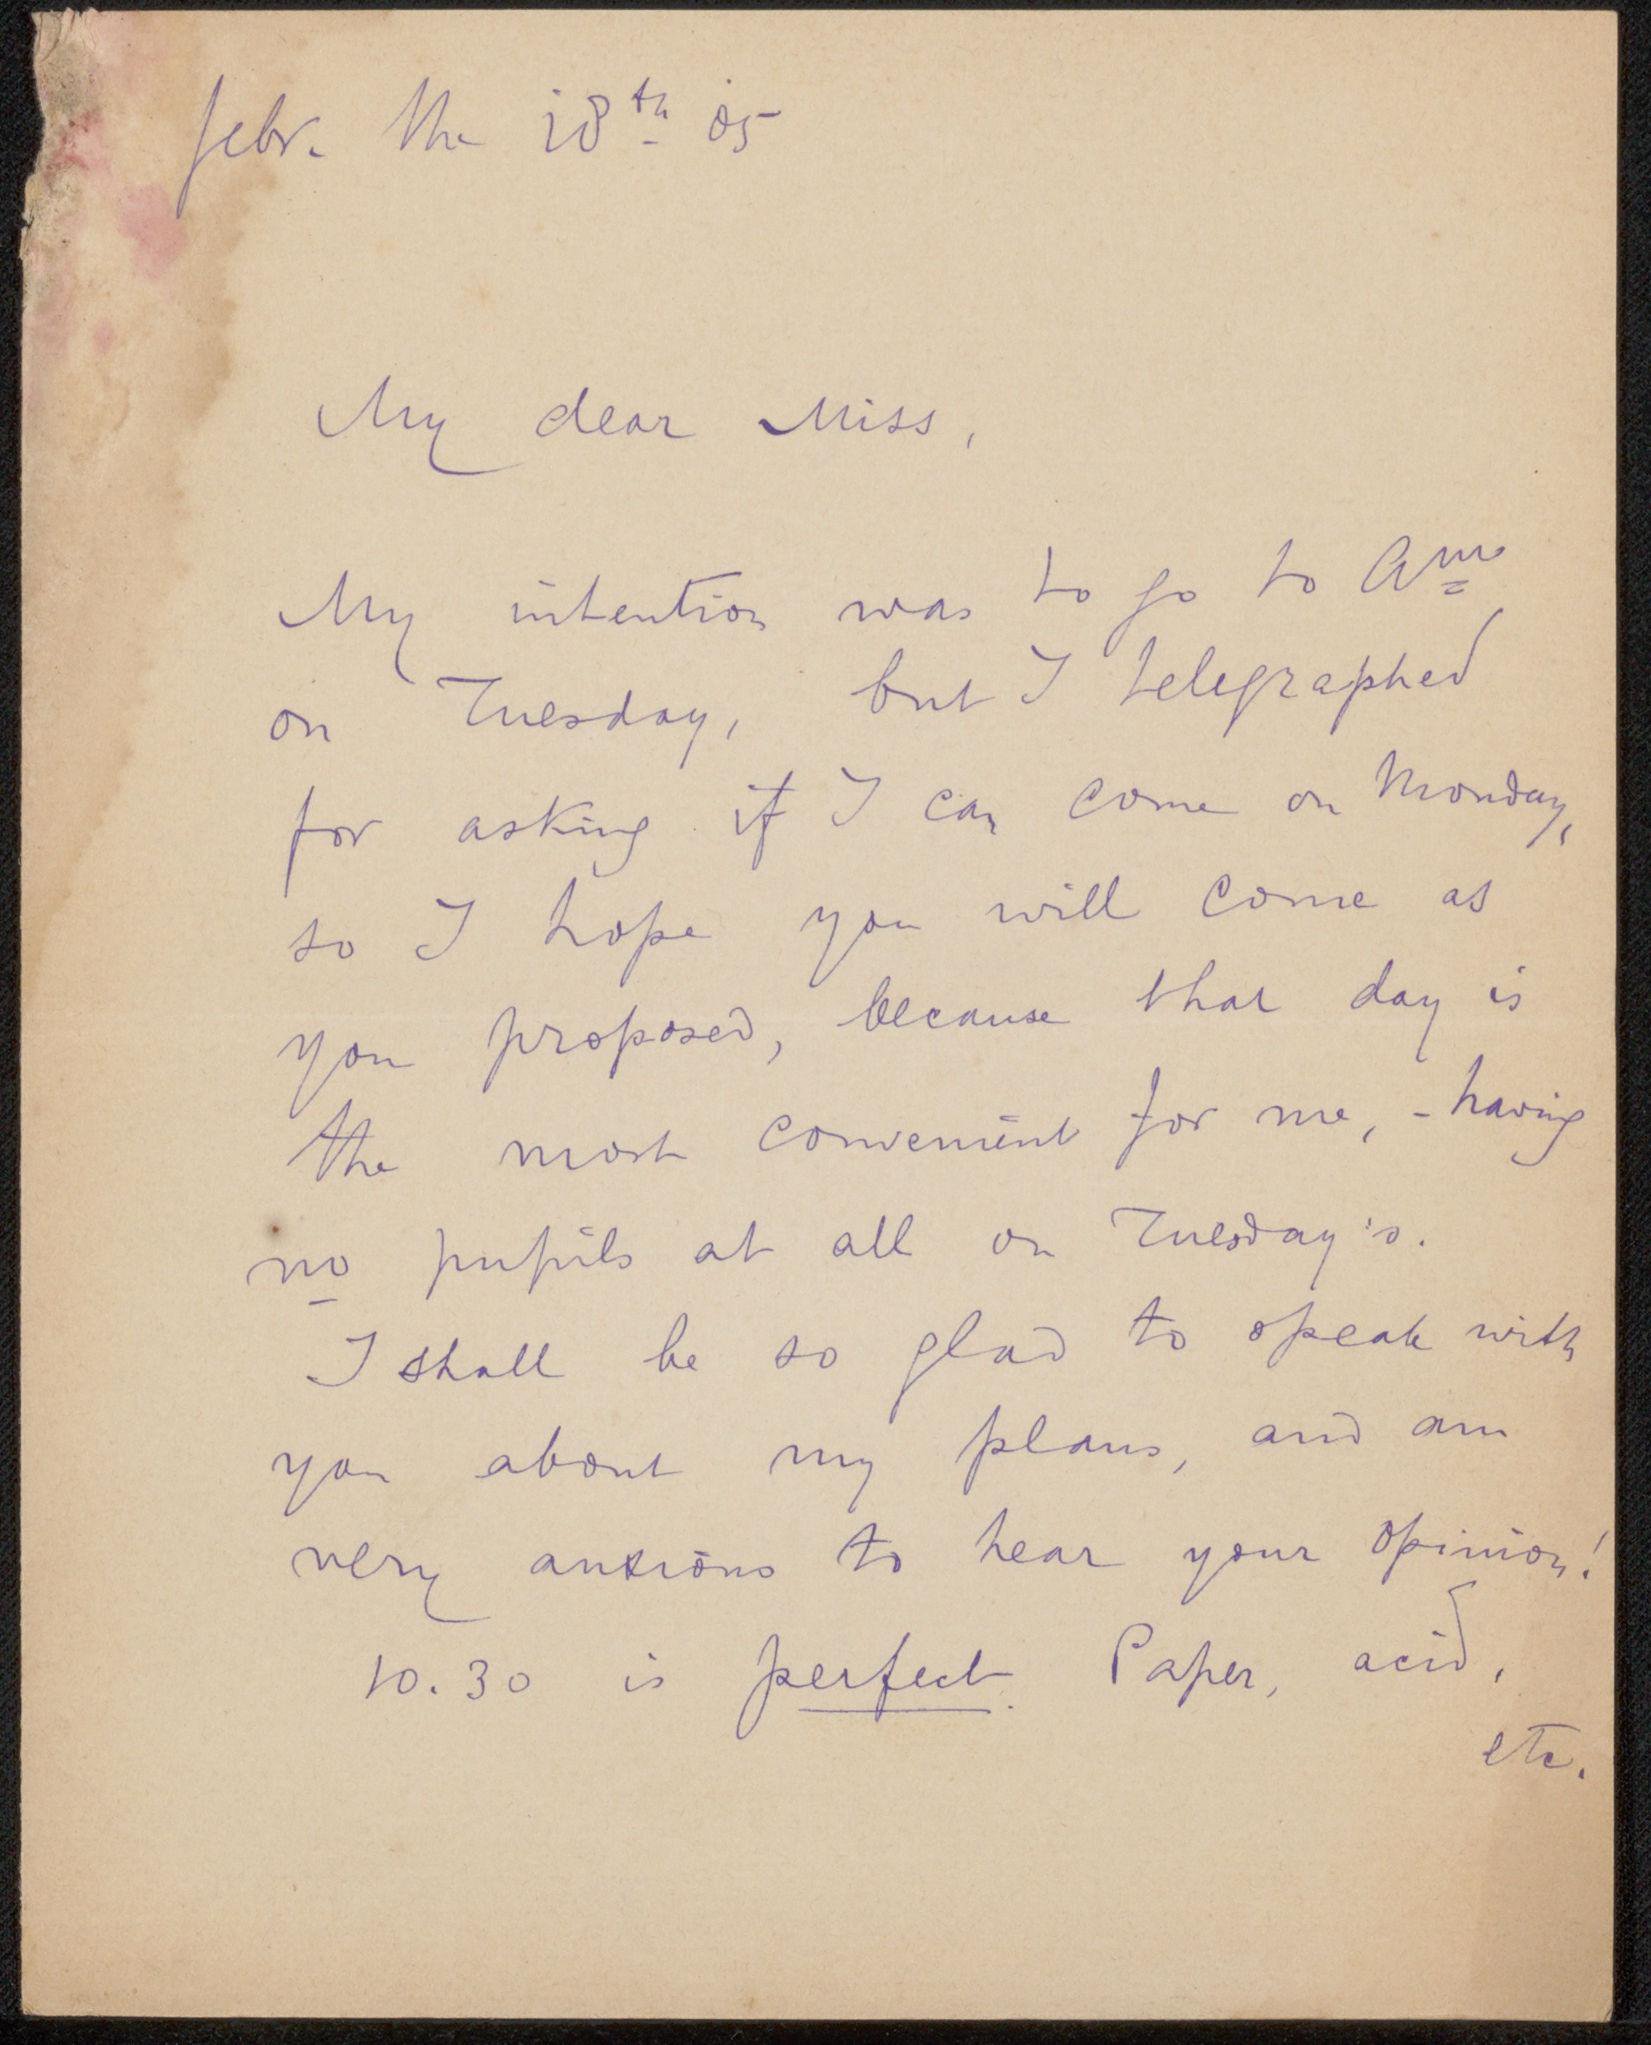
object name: letter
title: Brief aan Elsie Maud Cownie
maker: philip zilcken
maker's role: draughtsman, painter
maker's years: 1857-1930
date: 1905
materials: ink, paper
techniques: pen, writing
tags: print maker, alphonse legros, amsterdam, paul joseph constantin gabriël, manchester, the hague, draughtsman, elsie maud cownie, the graphic arts, education, tuition of the artist (in general), painting (including book-illumination, miniature-painting)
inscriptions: watermark